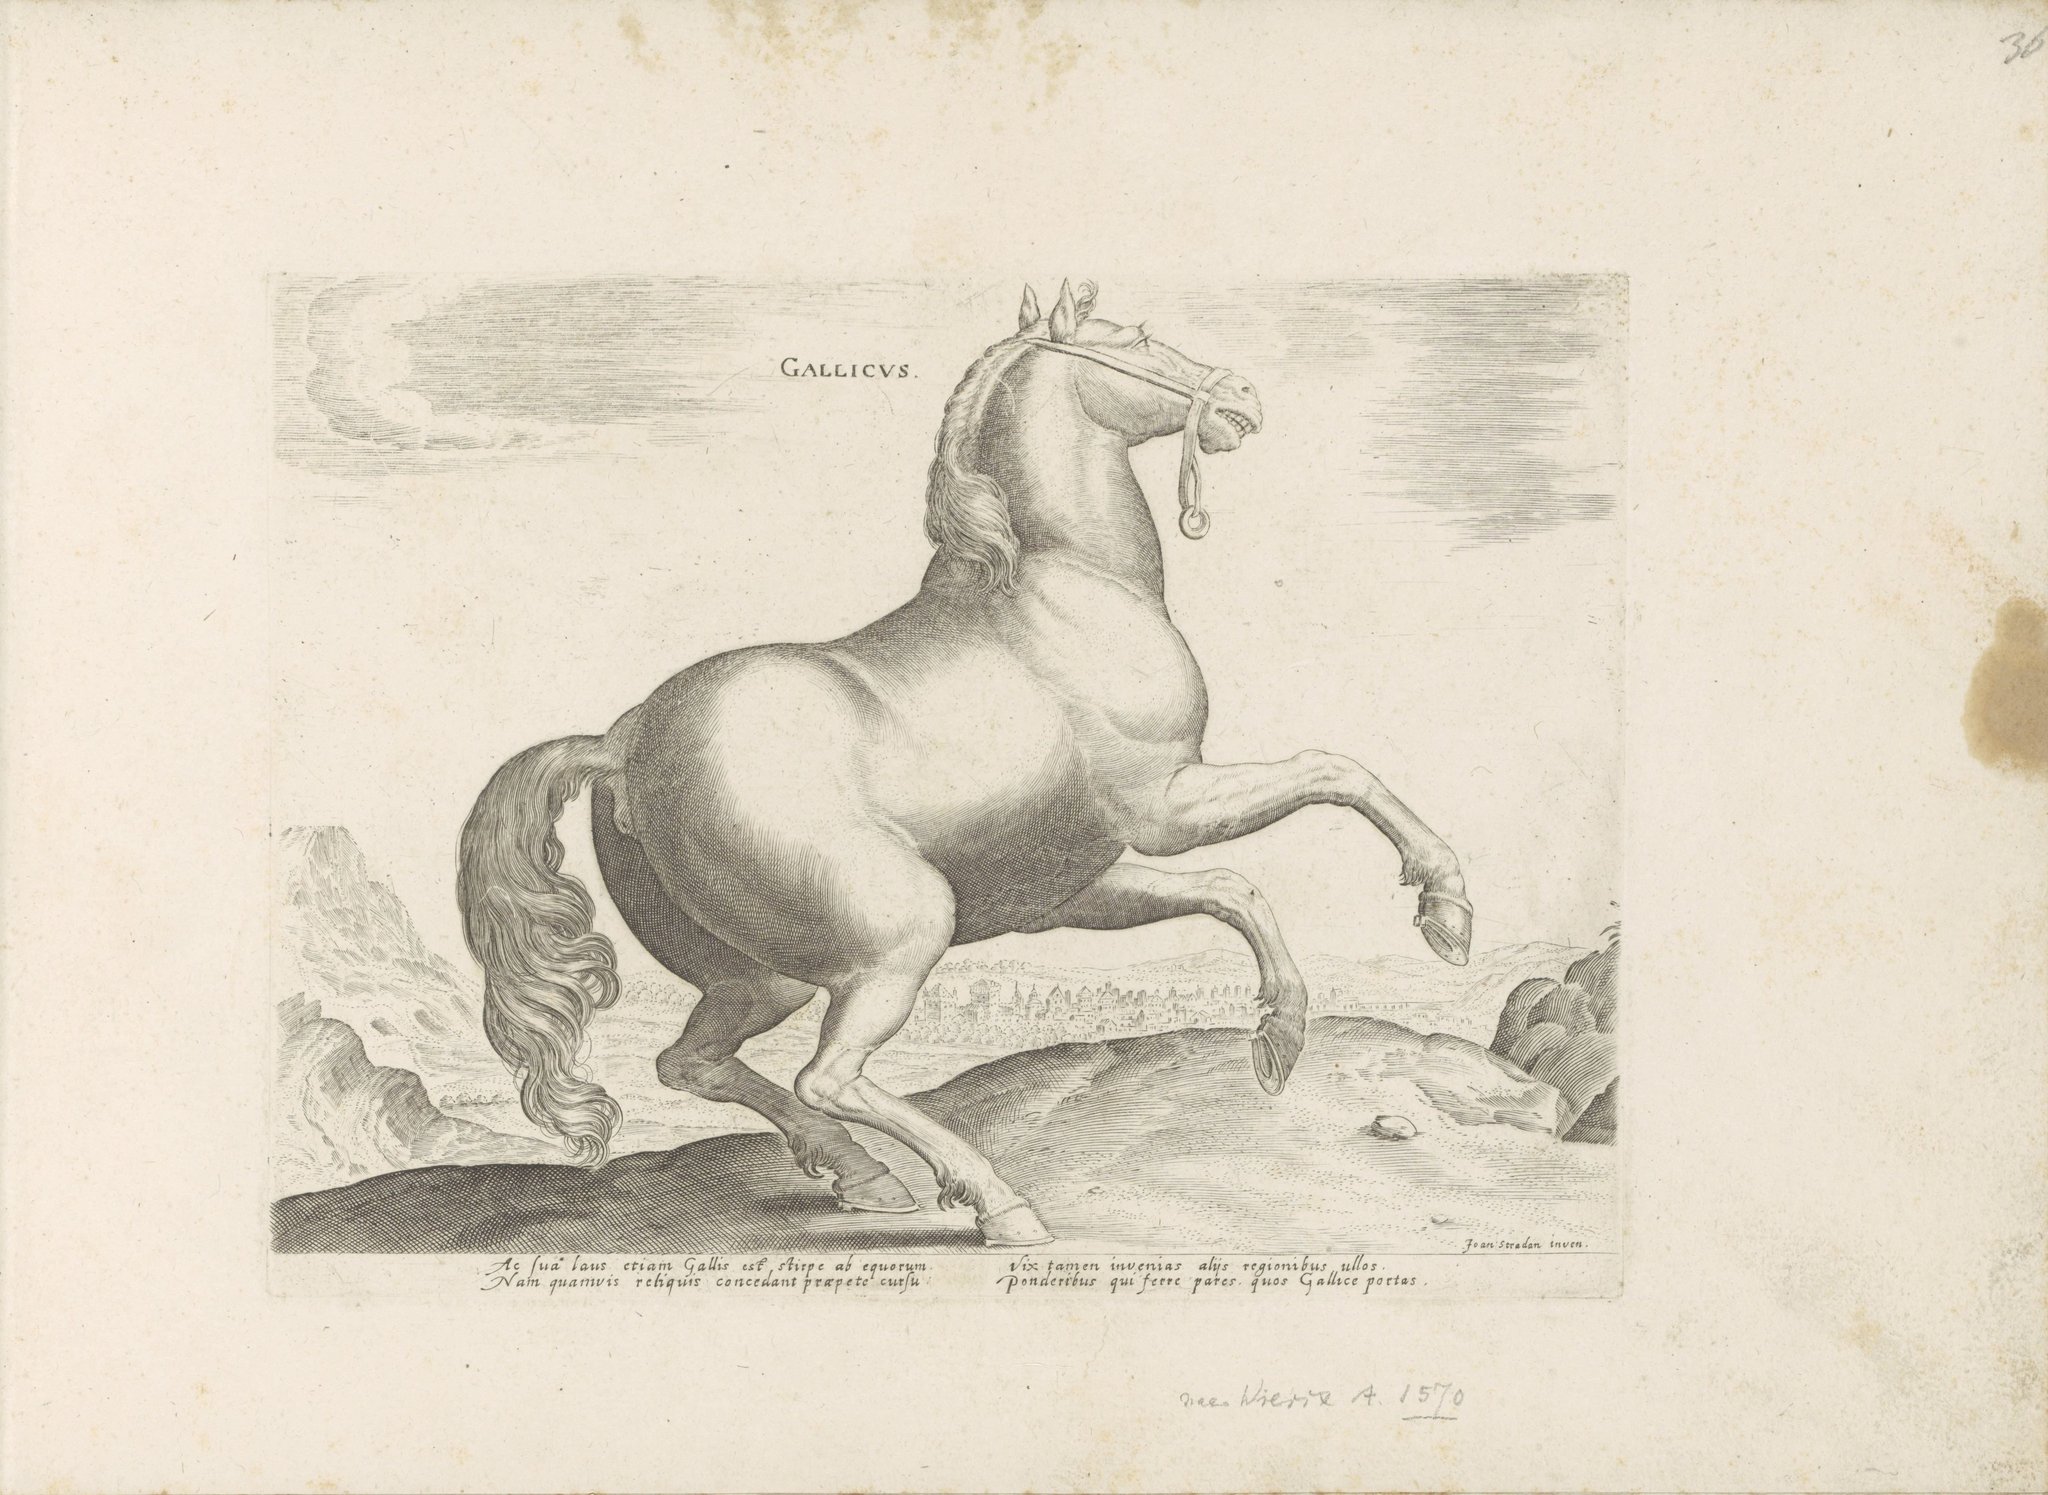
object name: print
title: Gallicus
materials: paper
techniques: engraving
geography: venice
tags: don juan van oostenrijk, horses and kindred animals, france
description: Een Frans paard in een landschap. Prent maakt deel uit van een album.